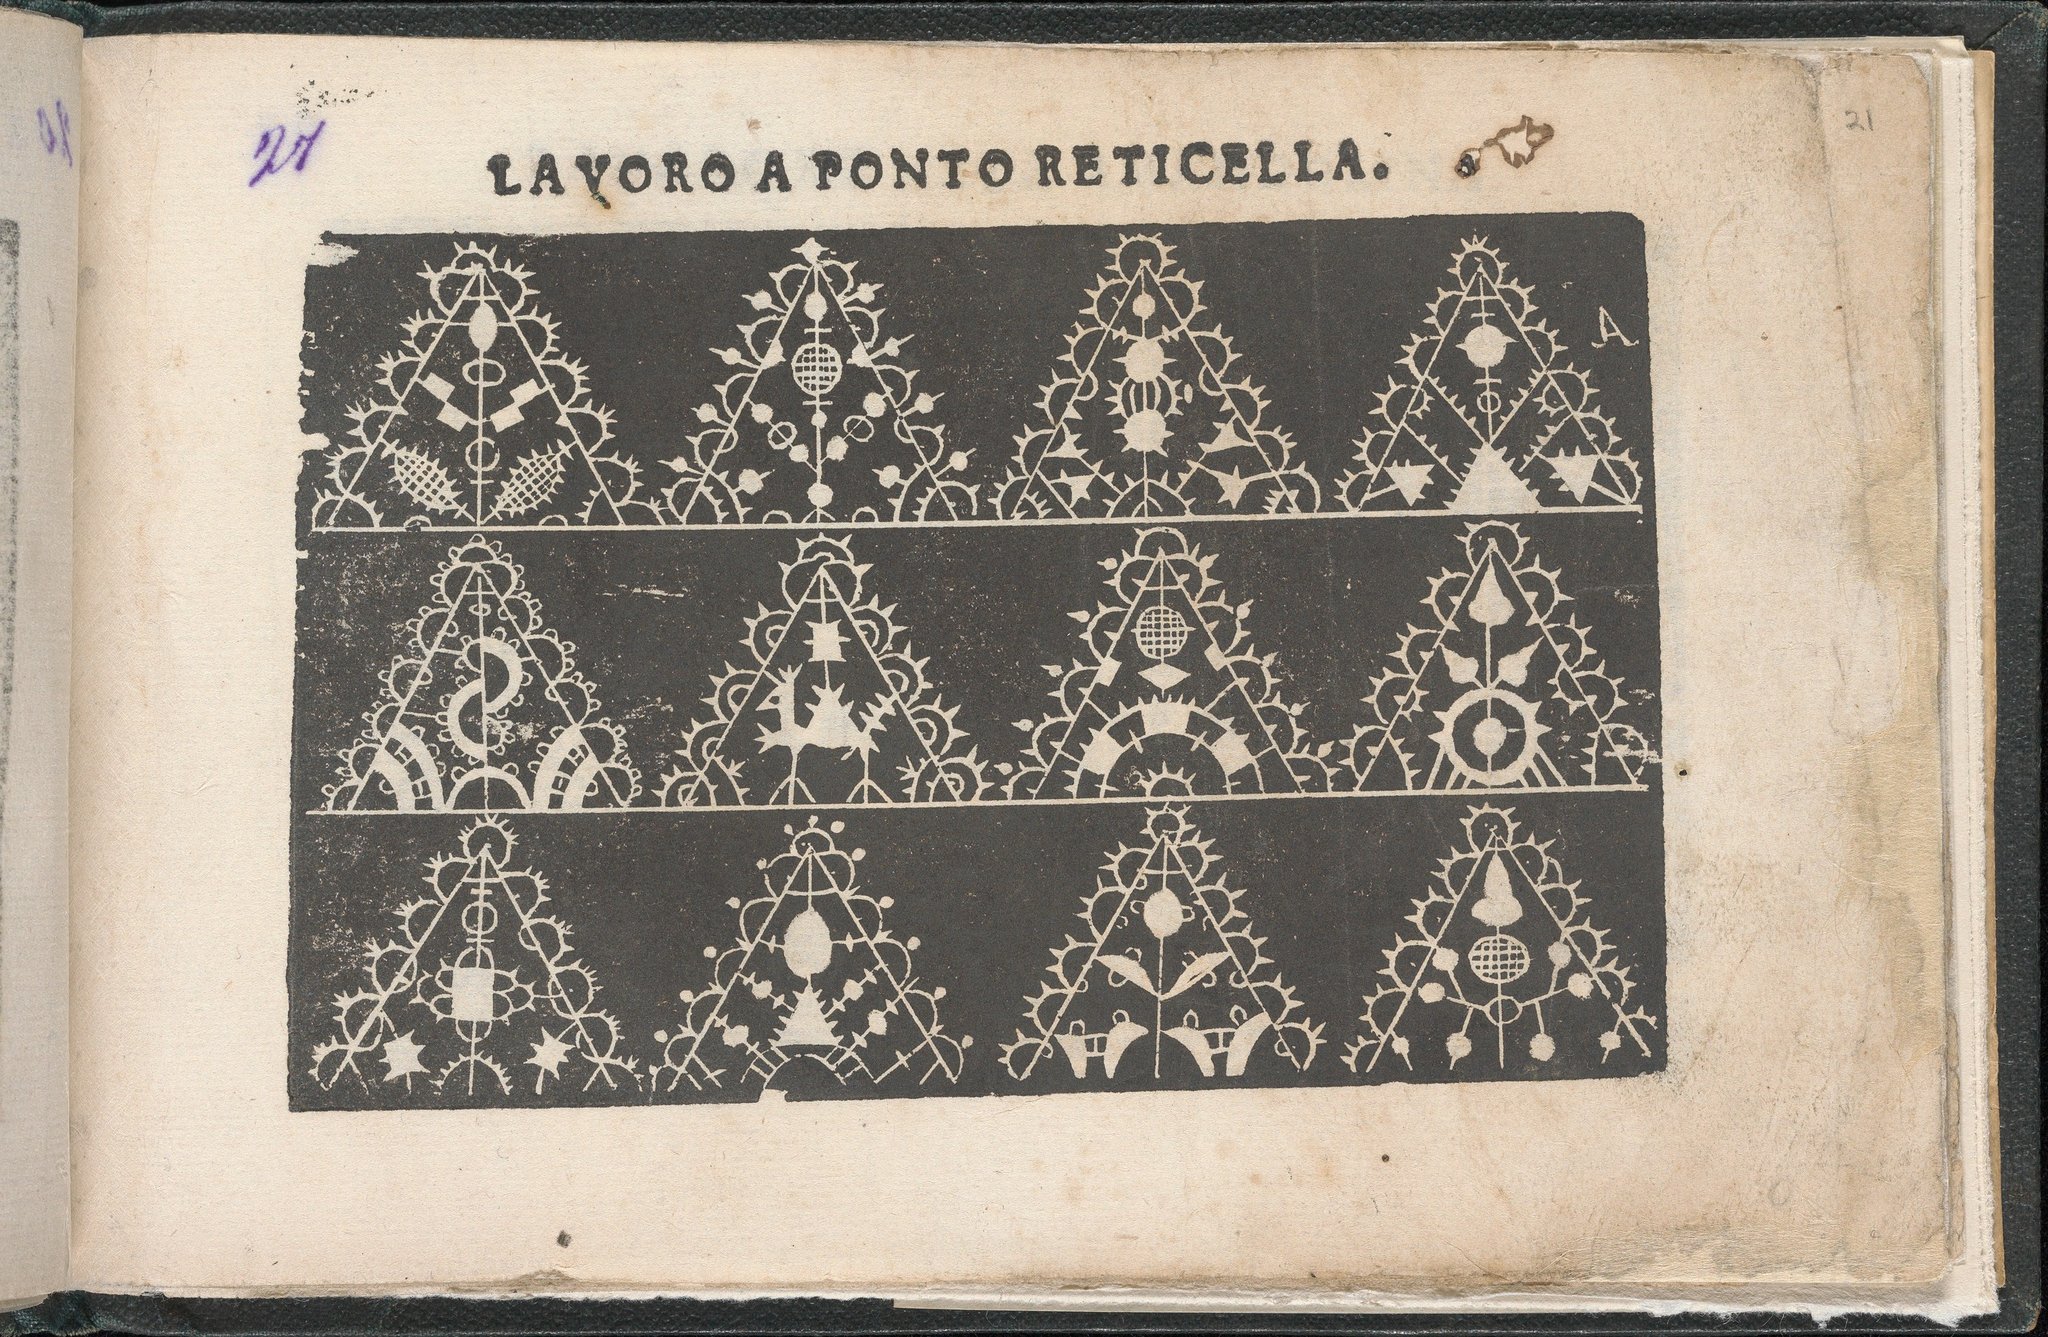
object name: book print ornament architecture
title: Gemma pretiosa della virtuose donne, page 21 (recto)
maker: isabella catanea parasole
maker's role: designer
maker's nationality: italian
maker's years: 1565-1625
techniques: woodcut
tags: ornament